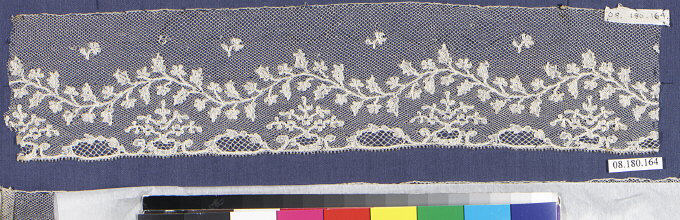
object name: piece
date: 1701-1800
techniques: lace